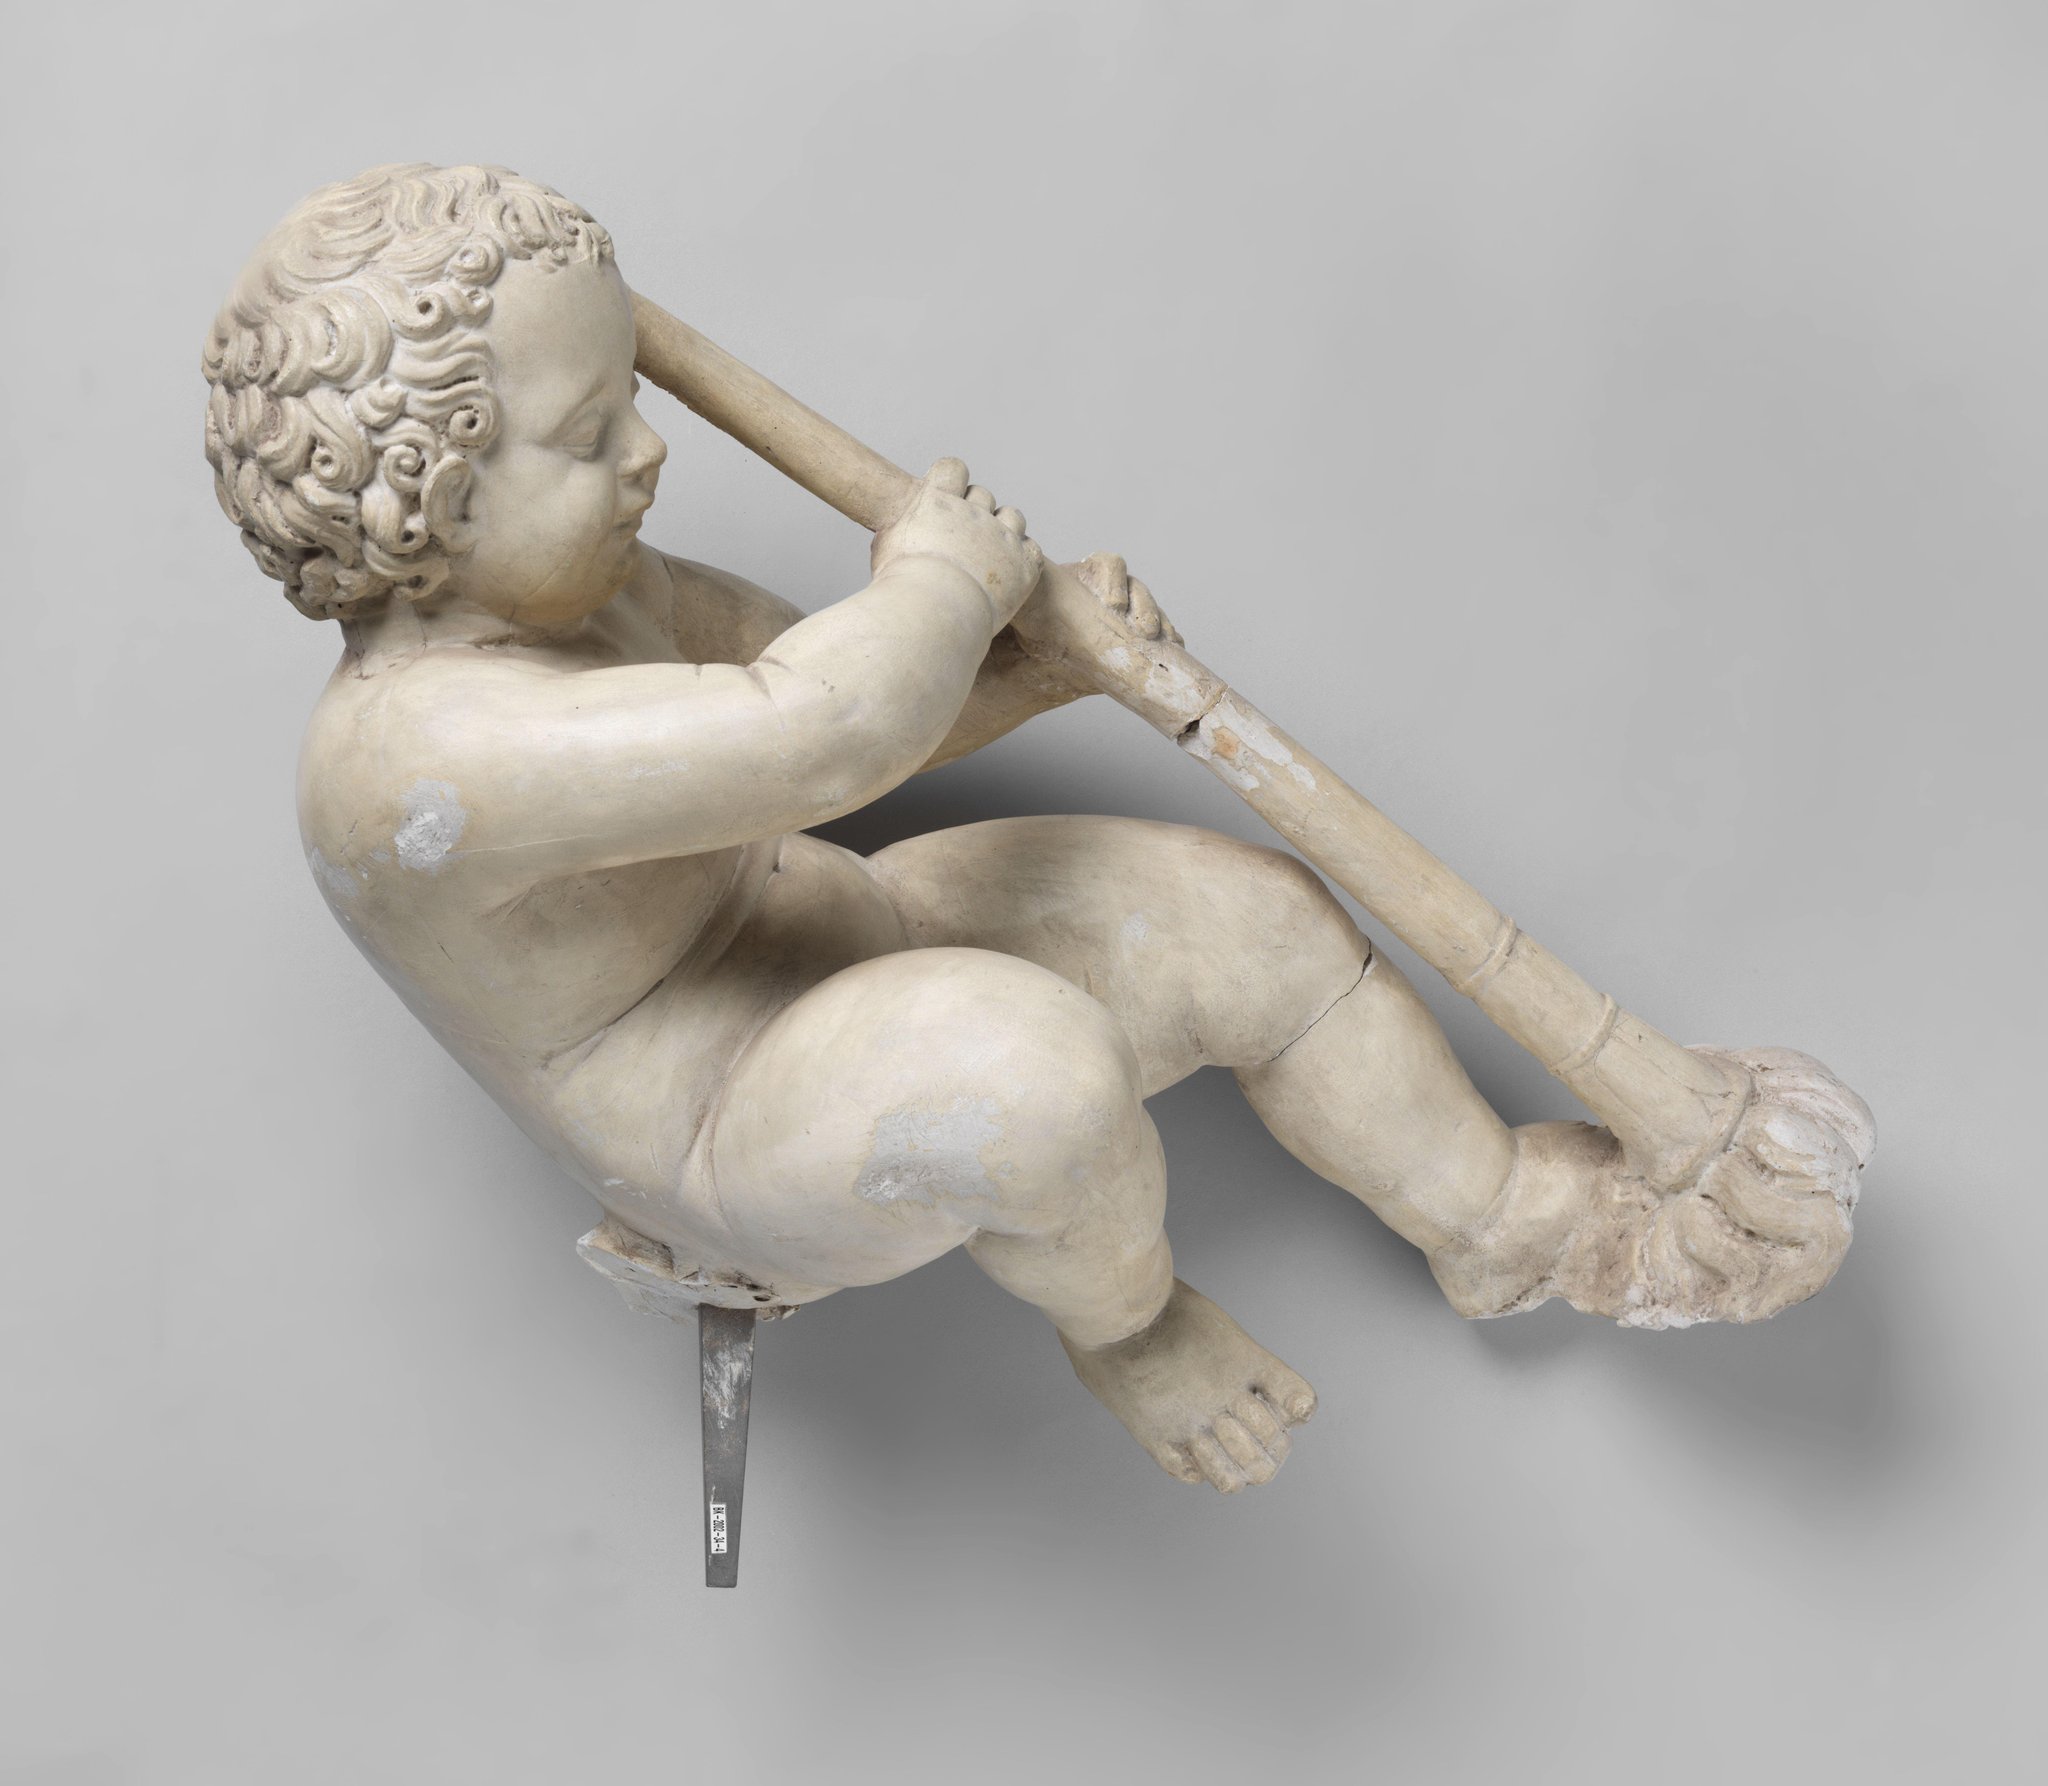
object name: cast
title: Putto horend bij het grafmonument van Paus Adrianus VI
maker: alberto galli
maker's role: sculptor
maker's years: 1840-1920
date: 1523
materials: gypsum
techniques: casting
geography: italy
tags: clergyman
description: Putto horend bij het grafmonument van Paus Adrianus VI, afgietsel in gips.